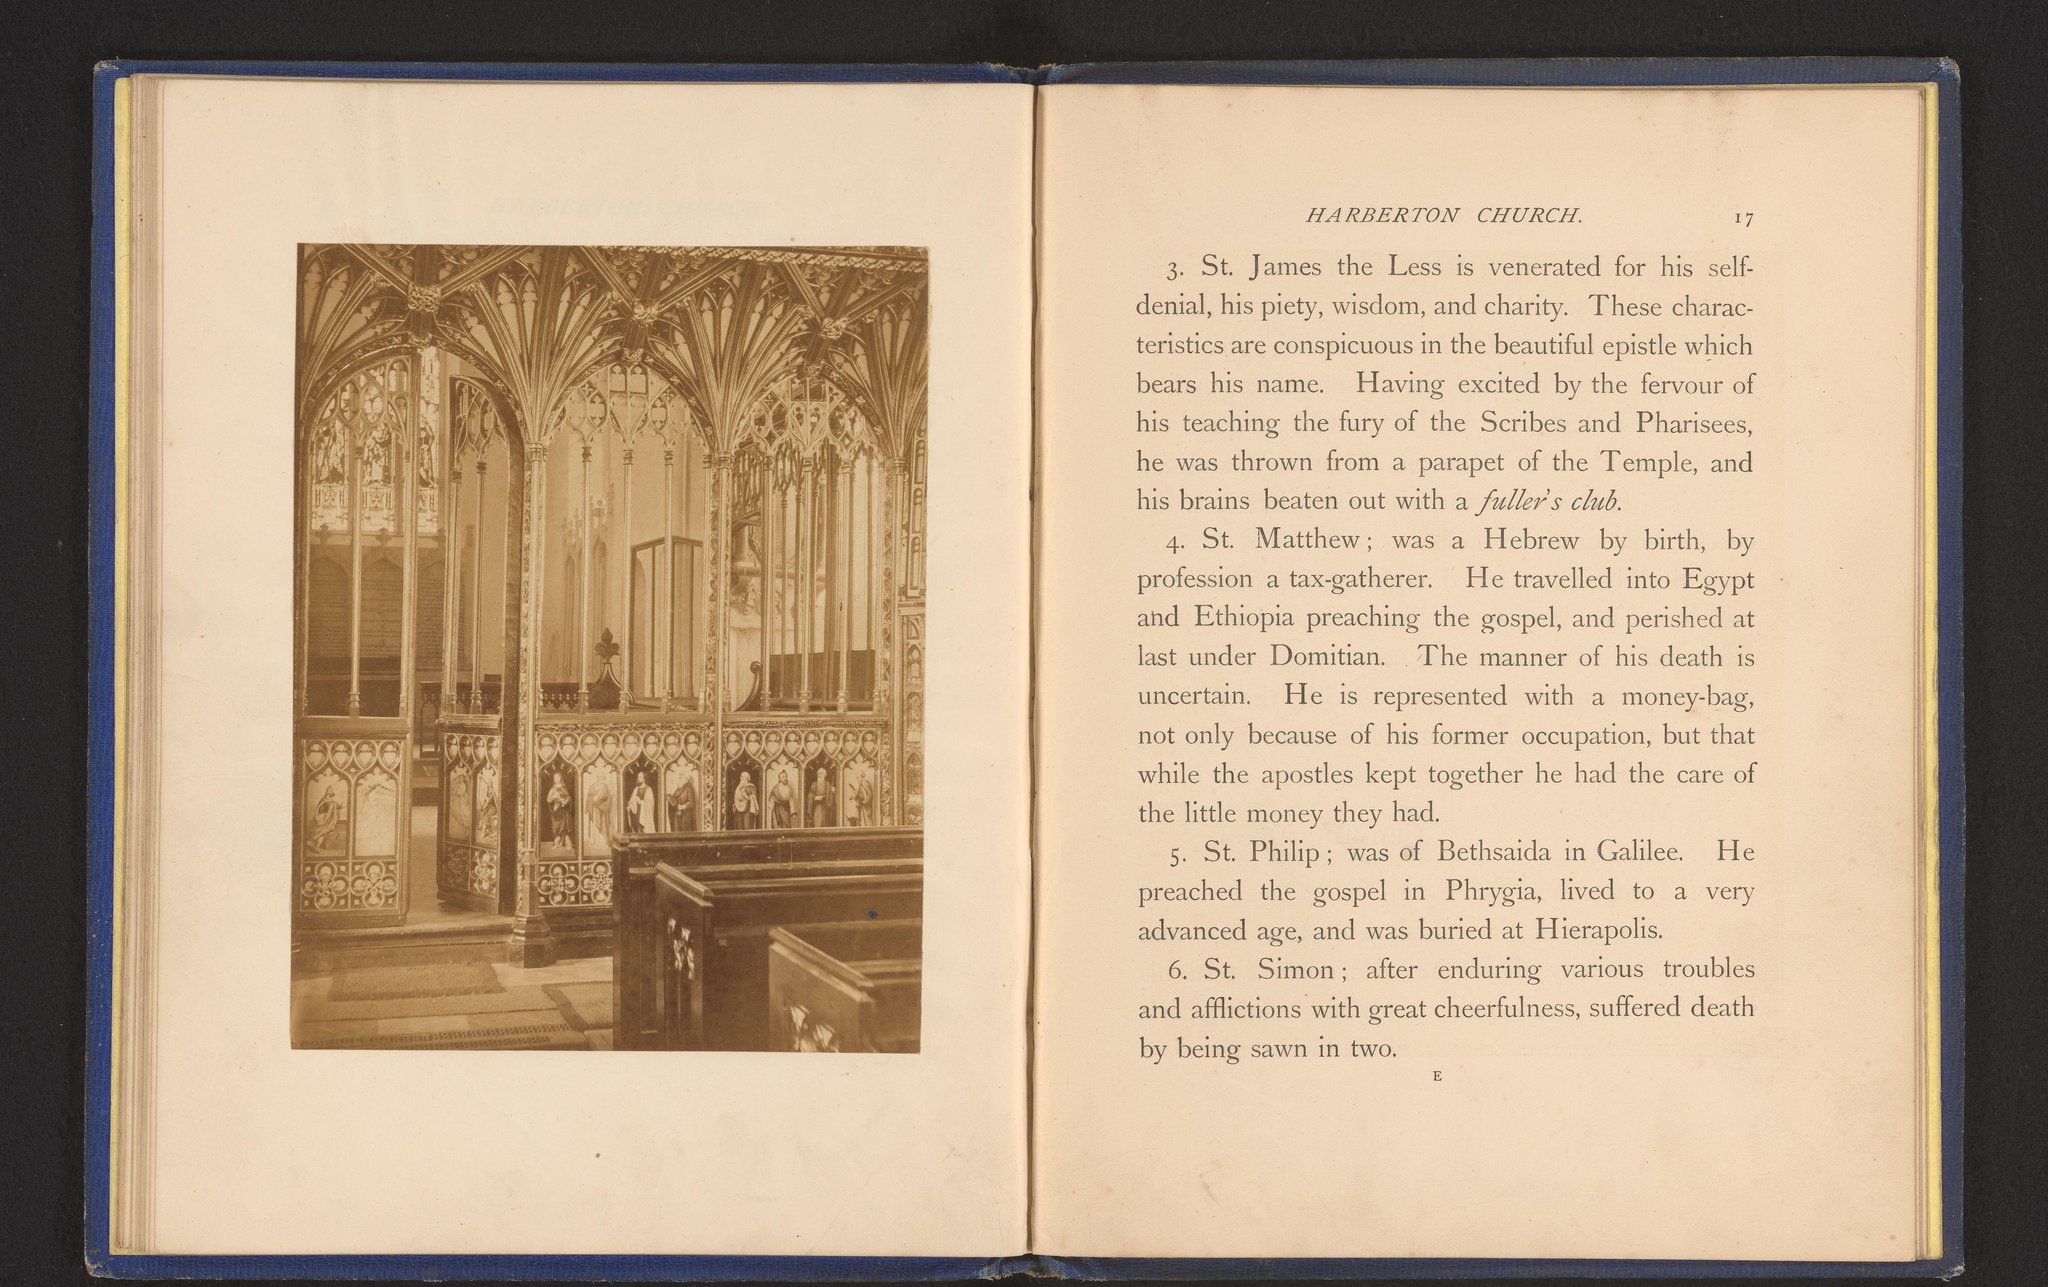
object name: photograph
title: Deel van het doksaal in Harberton Church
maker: Anonymous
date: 1867-1872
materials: paper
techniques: albumen print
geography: harberton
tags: rood-screen, choir-screen; iconostasis